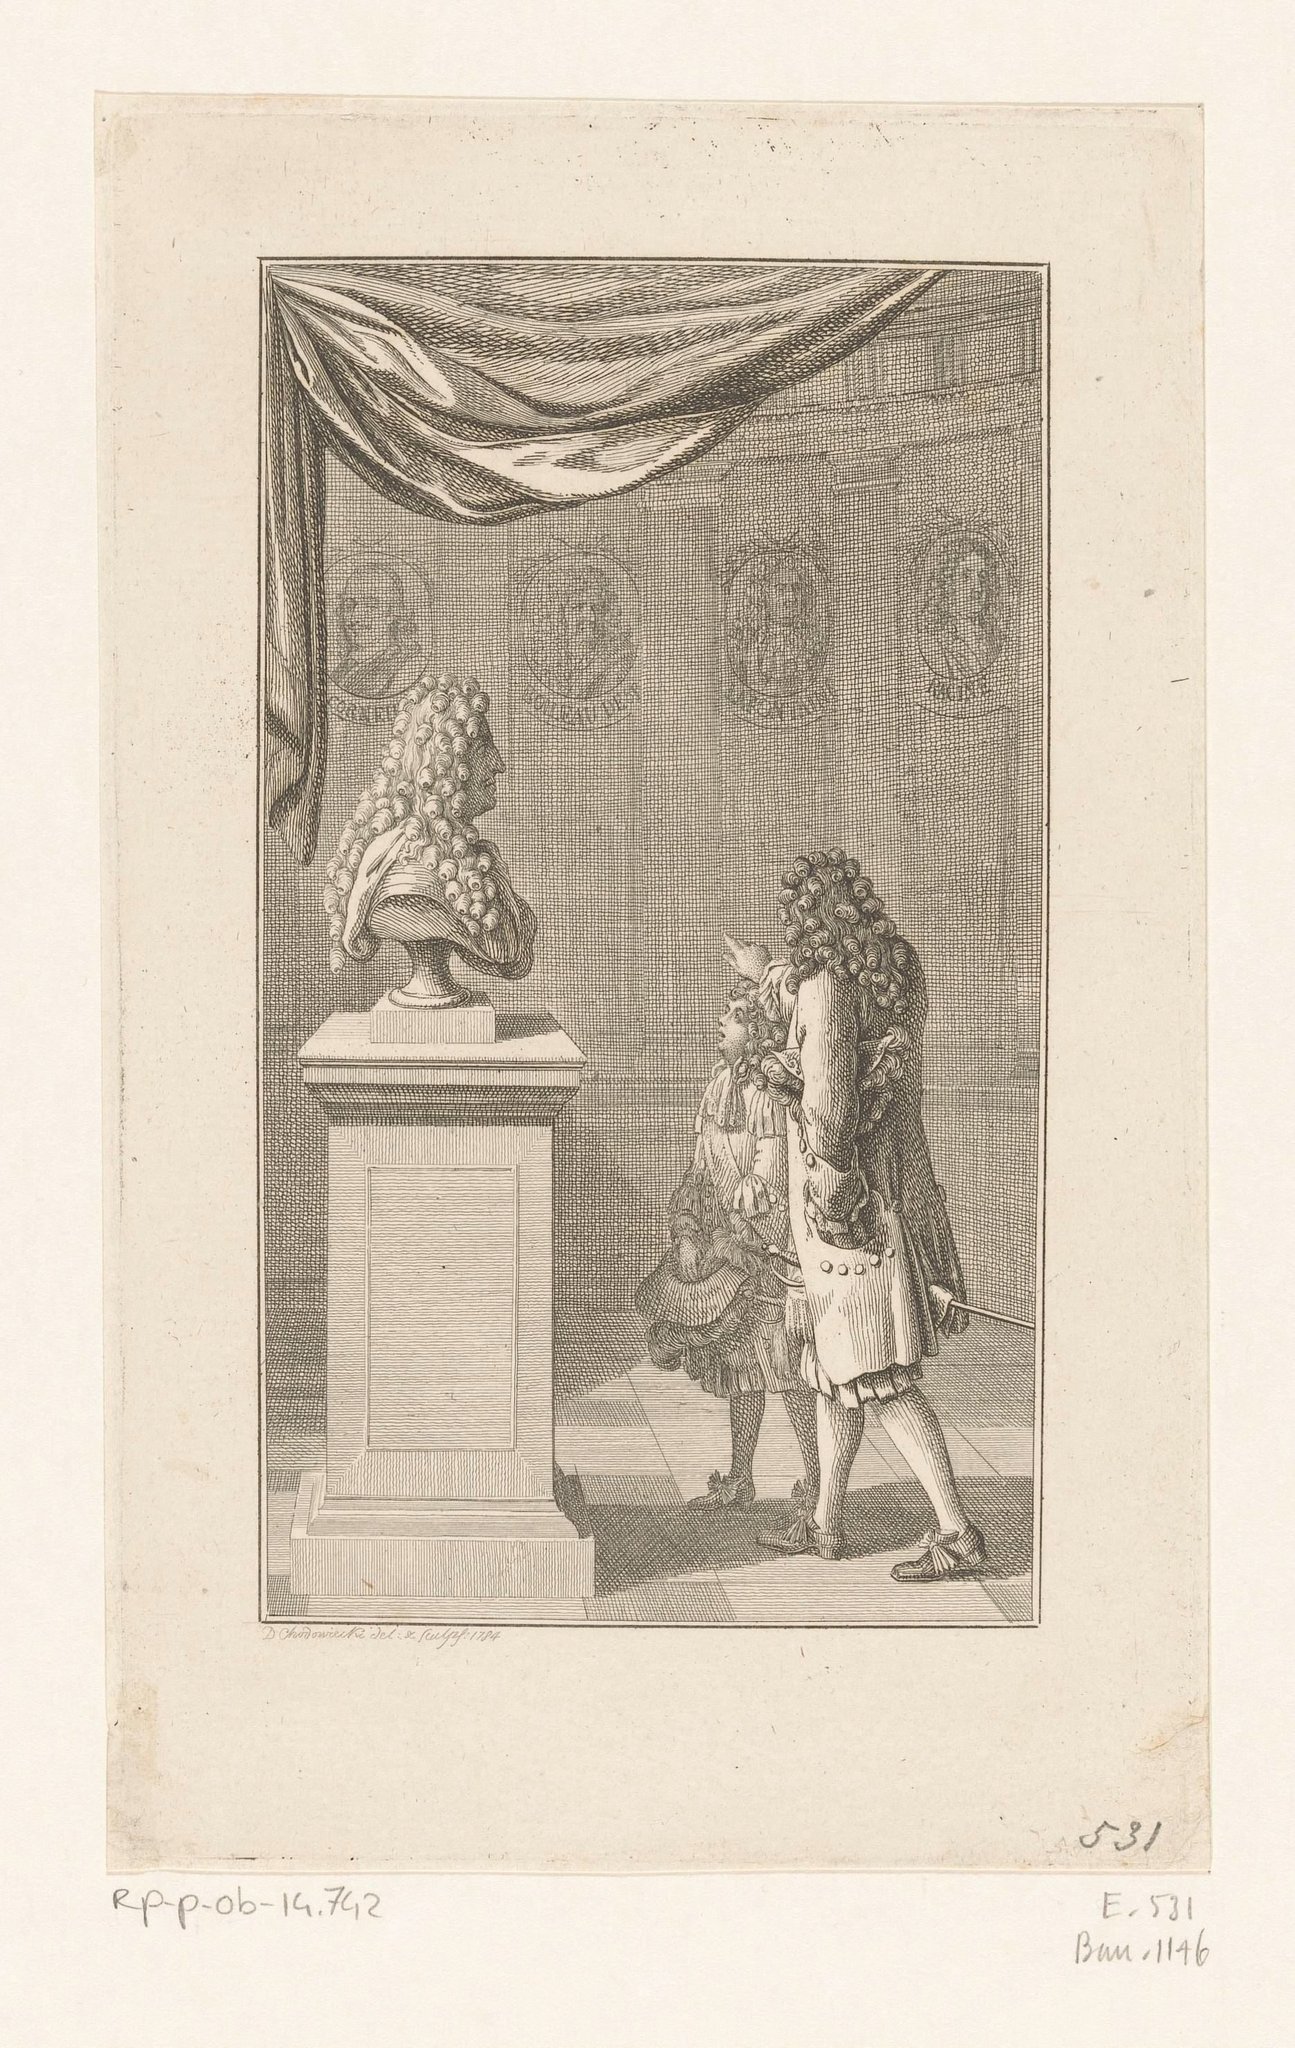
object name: print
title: Man laat jongen het borstbeeld van Lodewijk XIV zien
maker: daniel nikolaus chodowiecki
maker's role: draughtsman, print maker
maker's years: 1726-1801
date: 1784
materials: paper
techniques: etching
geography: berlin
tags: lodewijk xiv (koning van frankrijk), jean de la fontaine, paris, nicolas boileau, france, jean racine, pierre corneille, chest, bust, (feigned) picture curtain, portrait of a writer, index finger forwards, pointing, indicating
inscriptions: collector's mark: Lugt 2228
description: Prent gebruikt voor: De la Veaux, Theobald. Les vrais principes de la langue françoise. Neue französische Grammatik für den Teutschen (...). Berlijn: Christian Friedrich Himburg, 1785.